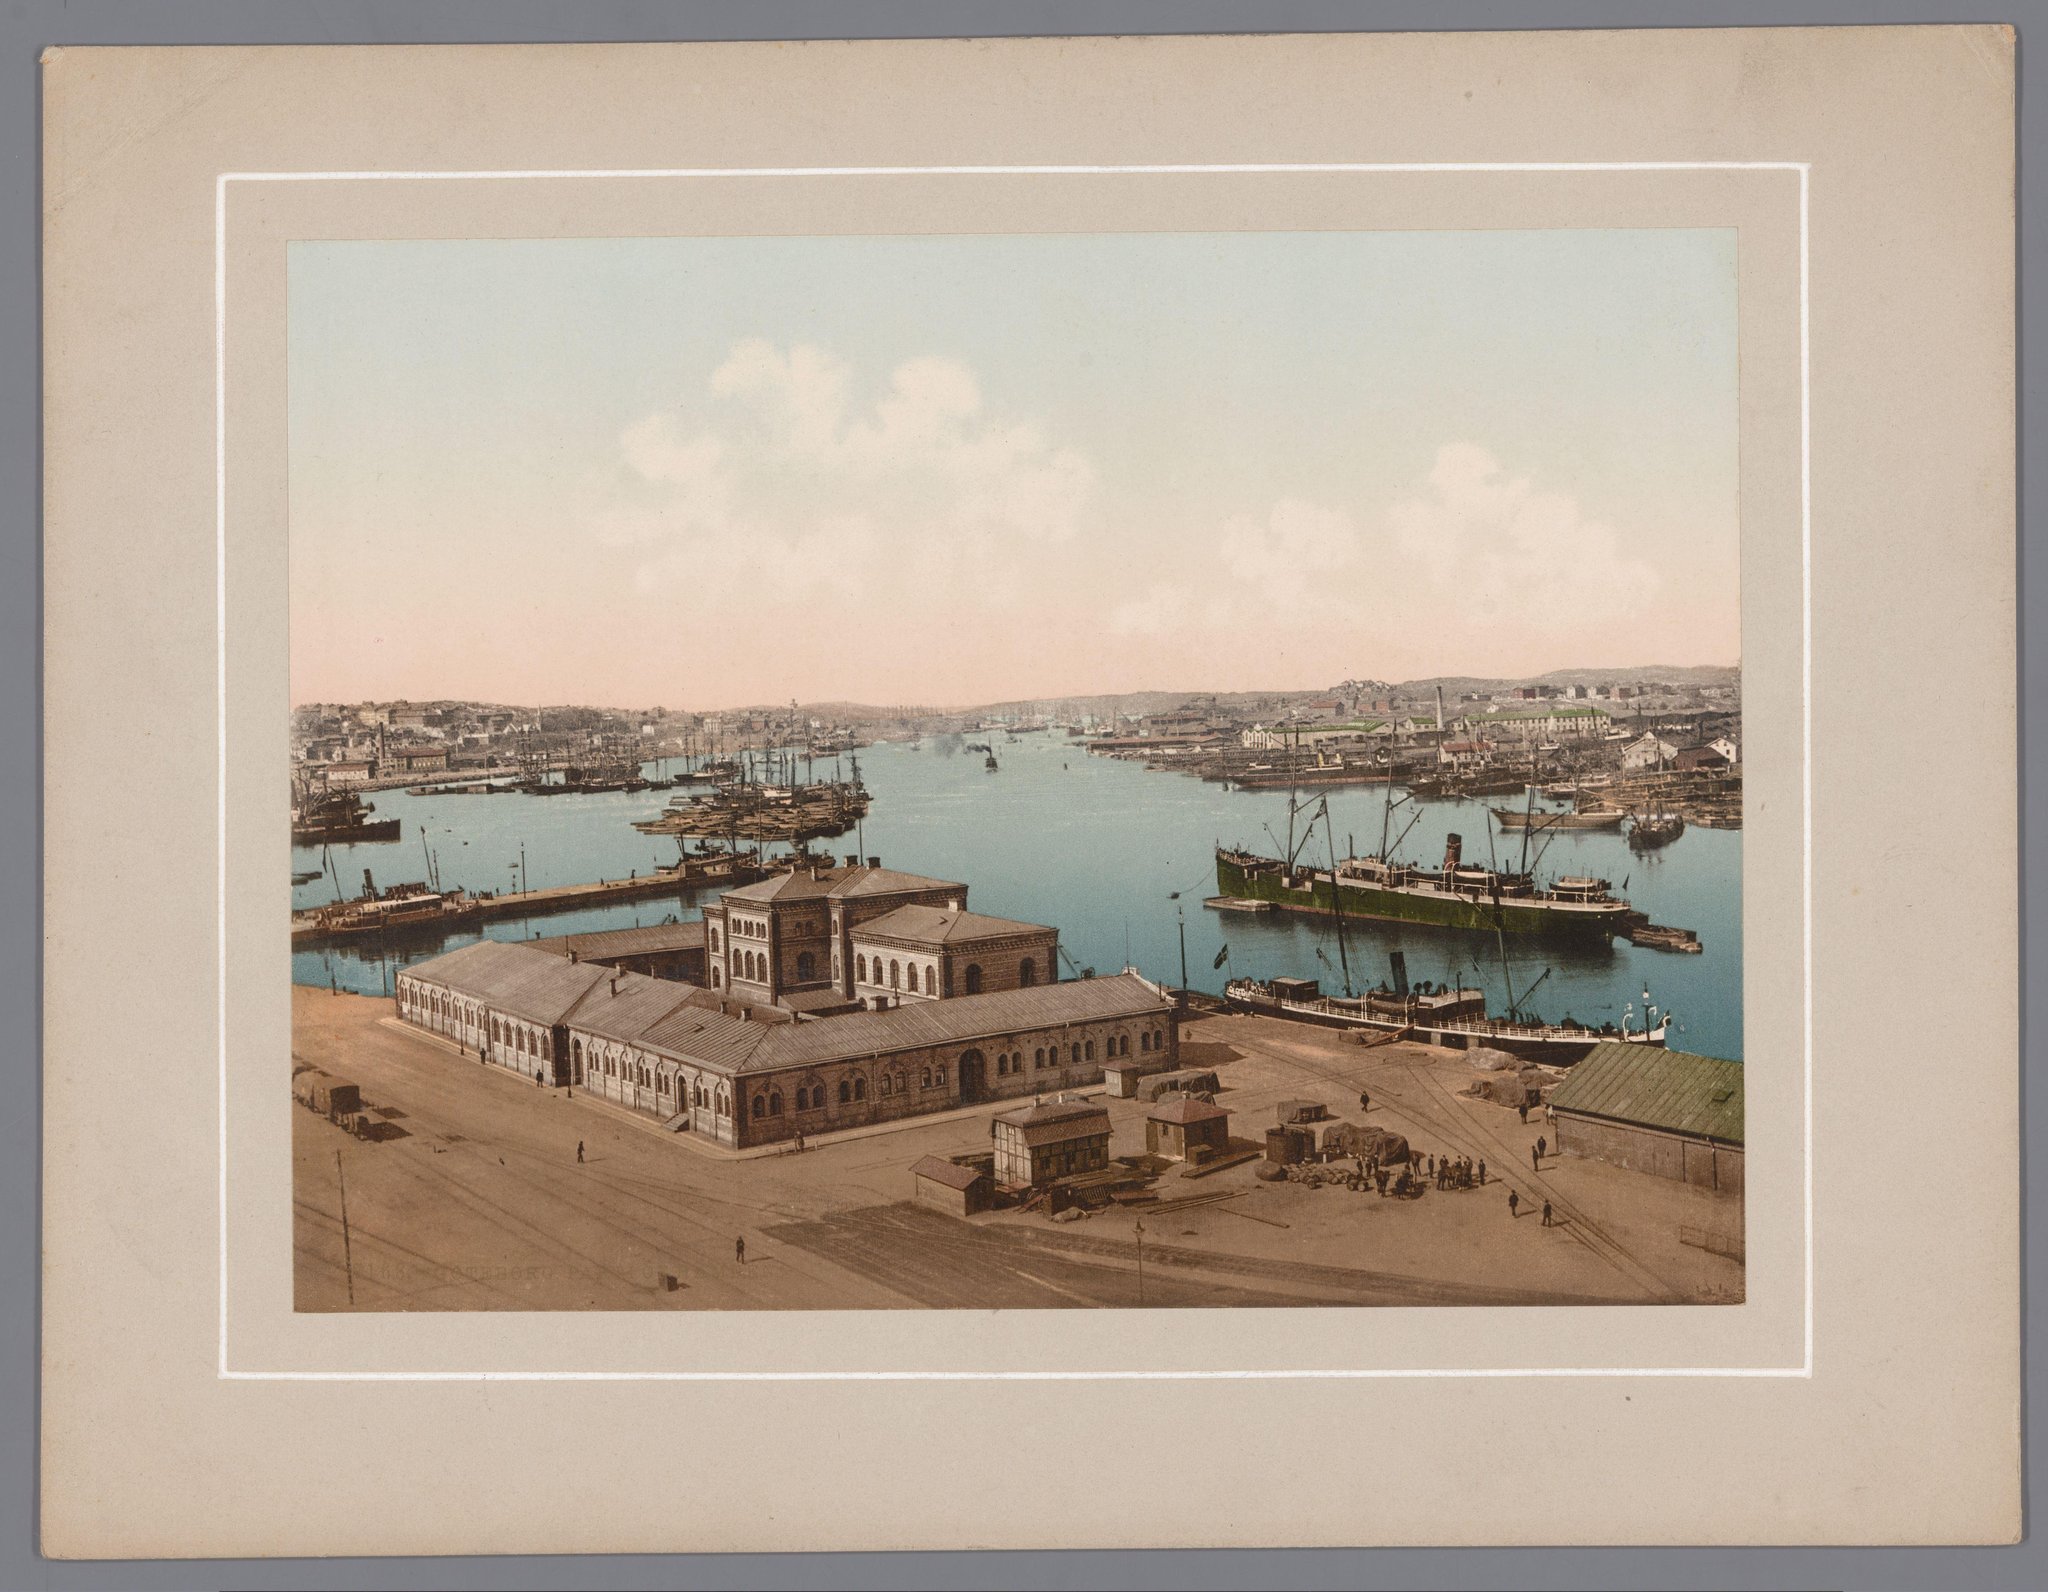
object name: photomechanical print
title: Gezicht op de haven van Göteborg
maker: Anonymous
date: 1889-1920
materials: cardboard, paper, photographic process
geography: zurich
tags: harbour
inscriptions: number: ‘7168.’